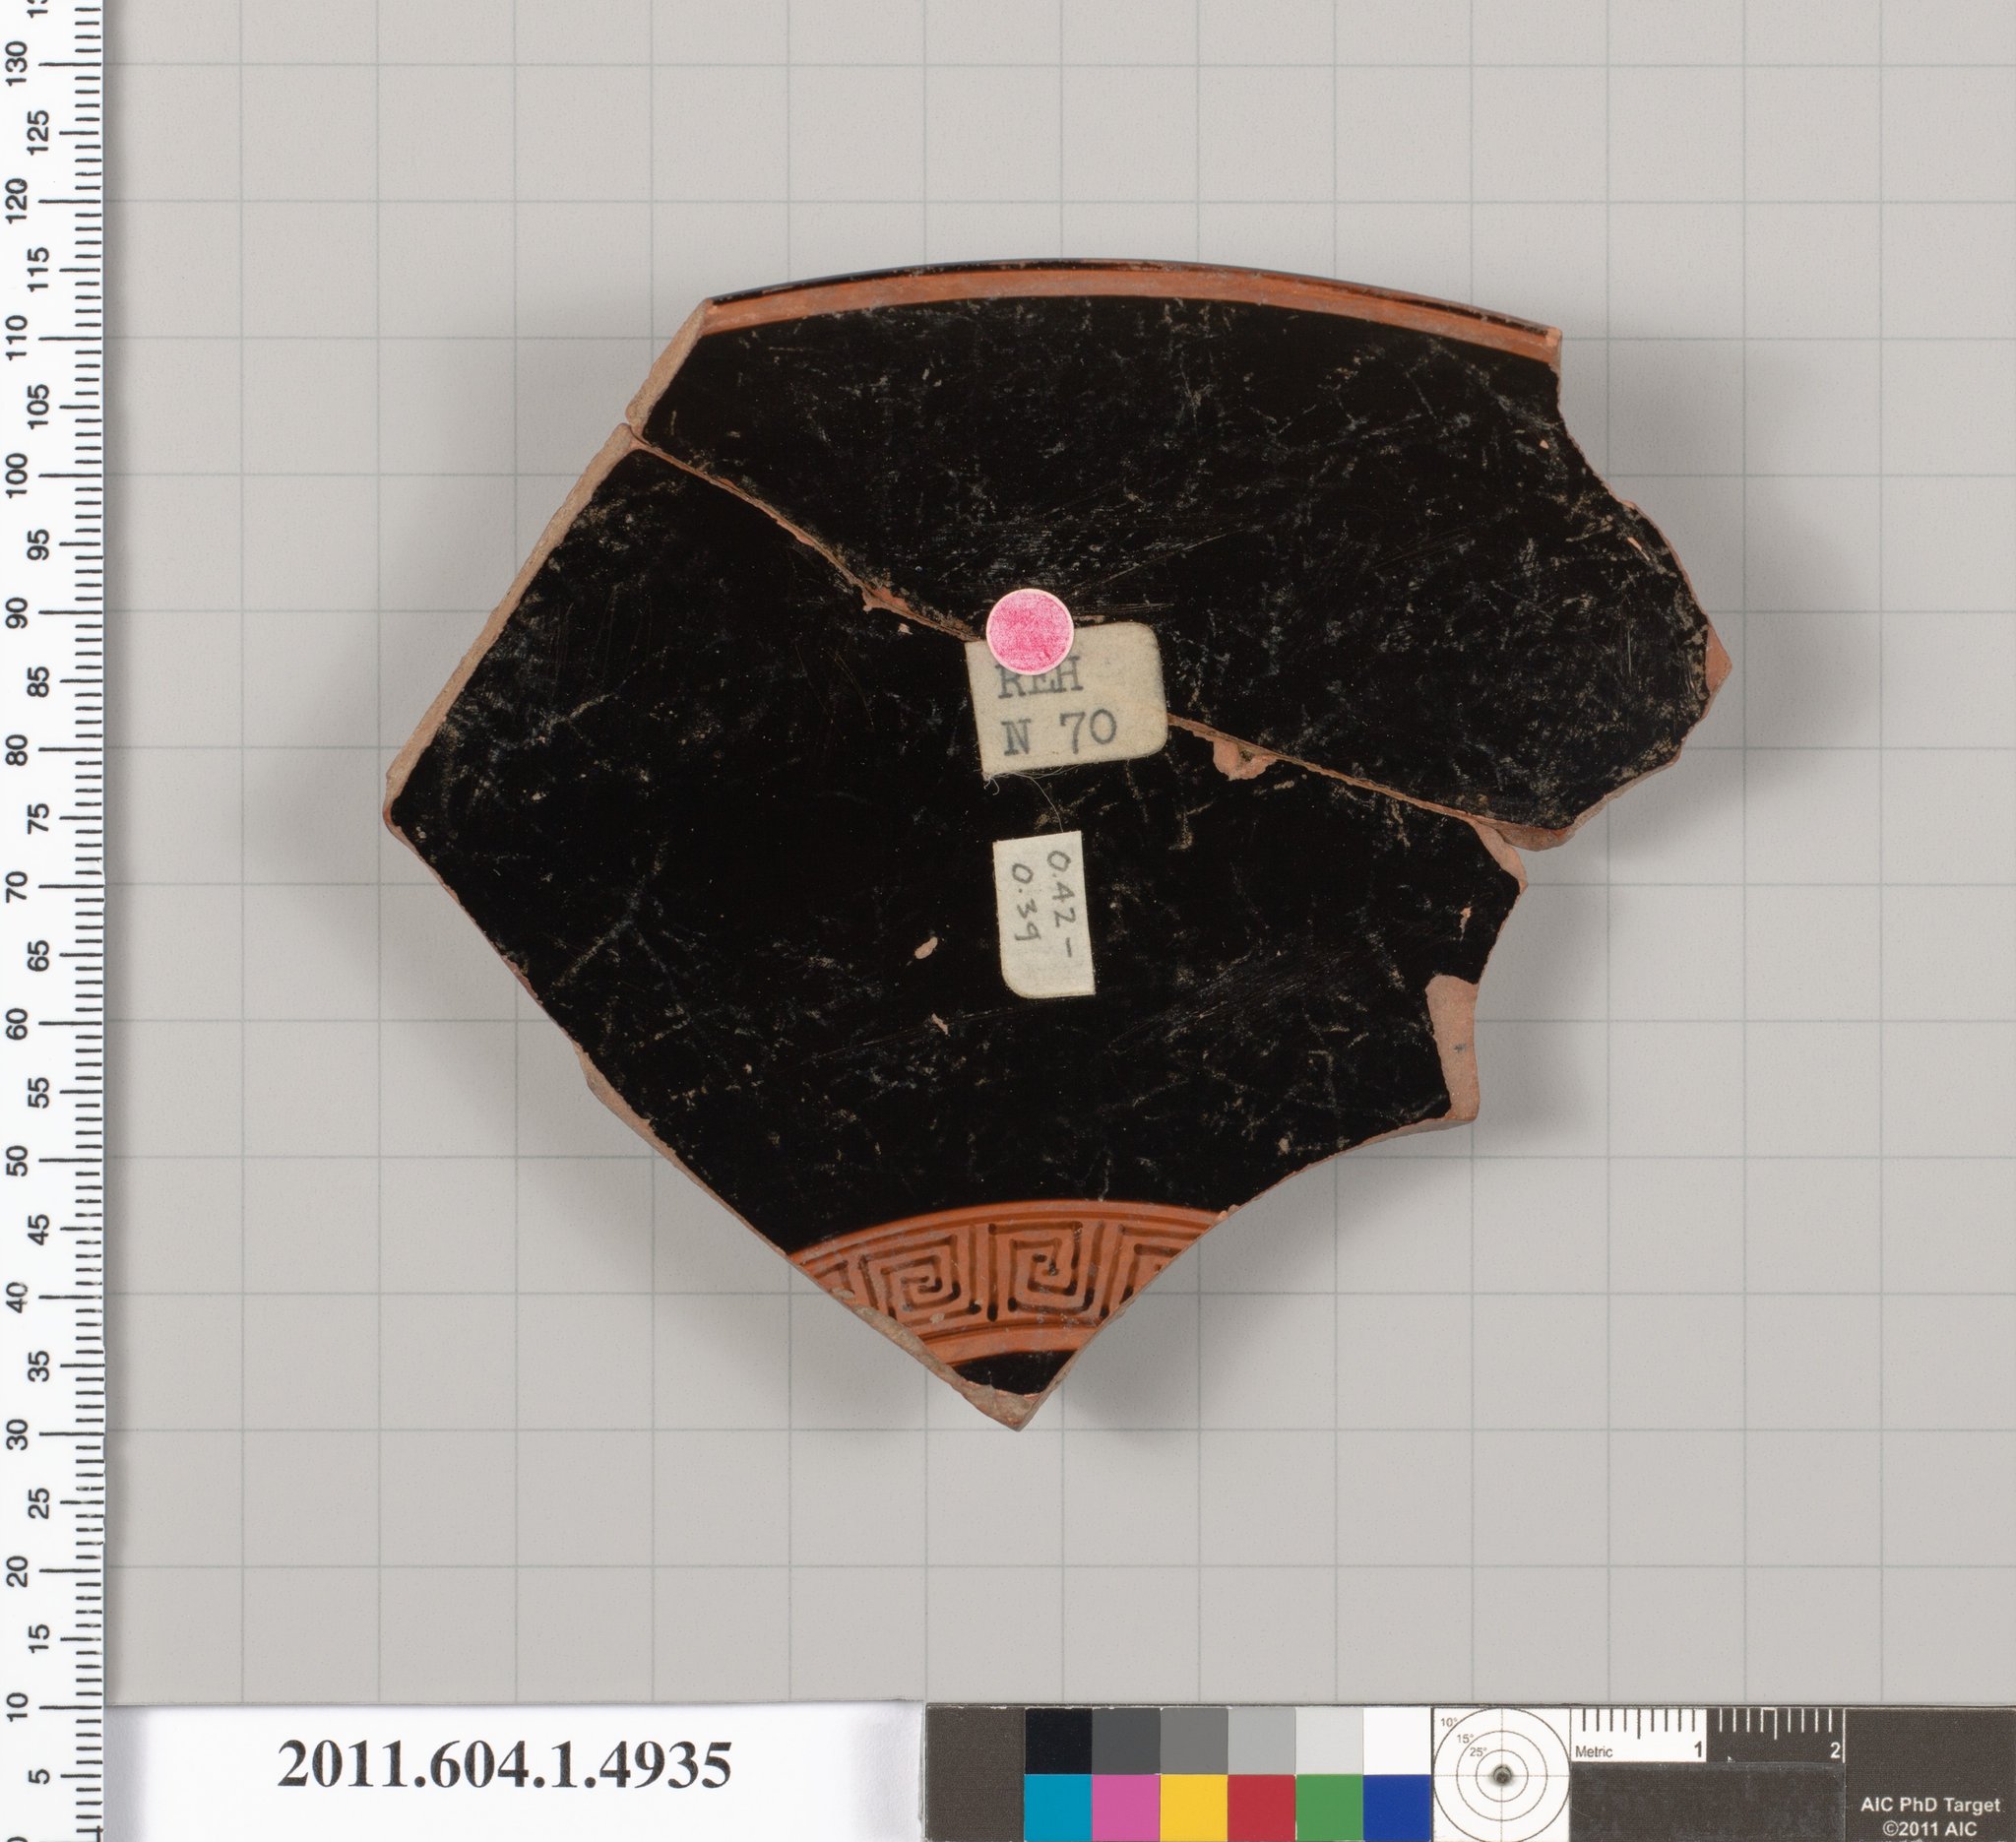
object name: kylix fragment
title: Terracotta rim fragment of a kylix (drinking cup)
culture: greek, attic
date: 460-450 BCE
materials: terracotta